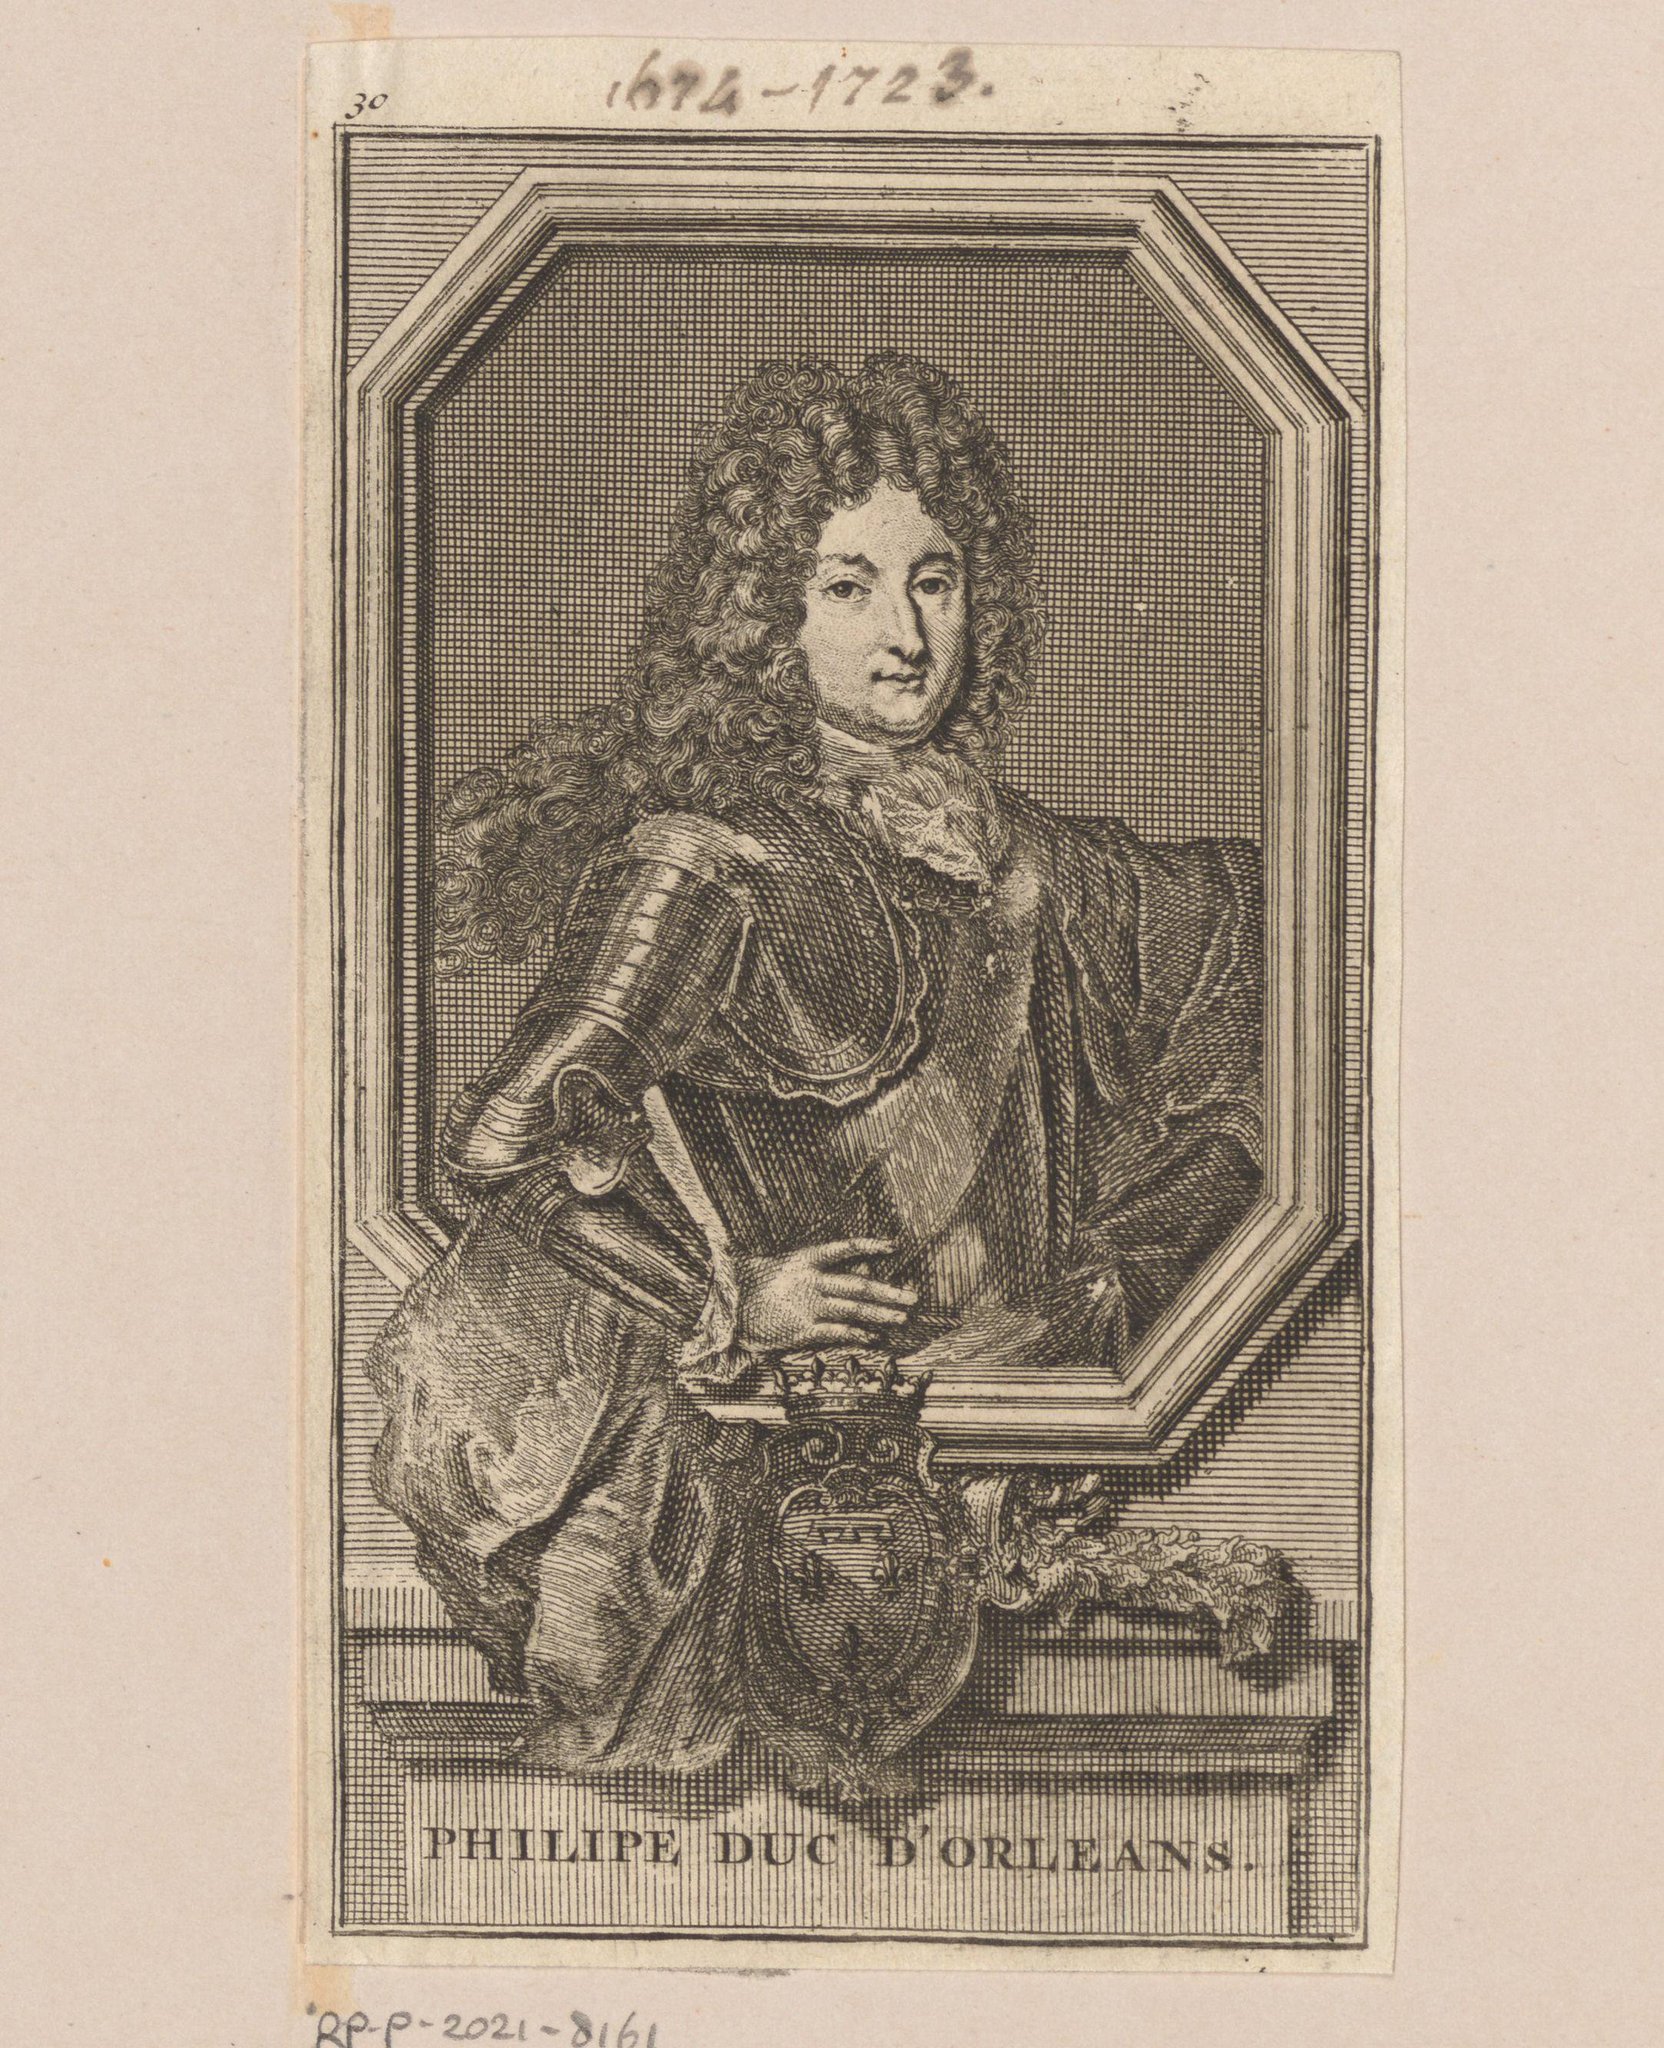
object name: print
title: Portret van Filips II, hertog van Orléans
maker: Anonymous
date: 1700-1749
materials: paper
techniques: engraving, etching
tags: filips ii (hertog van orléans), armour, adult man, historical persons, armorial bearing, heraldry